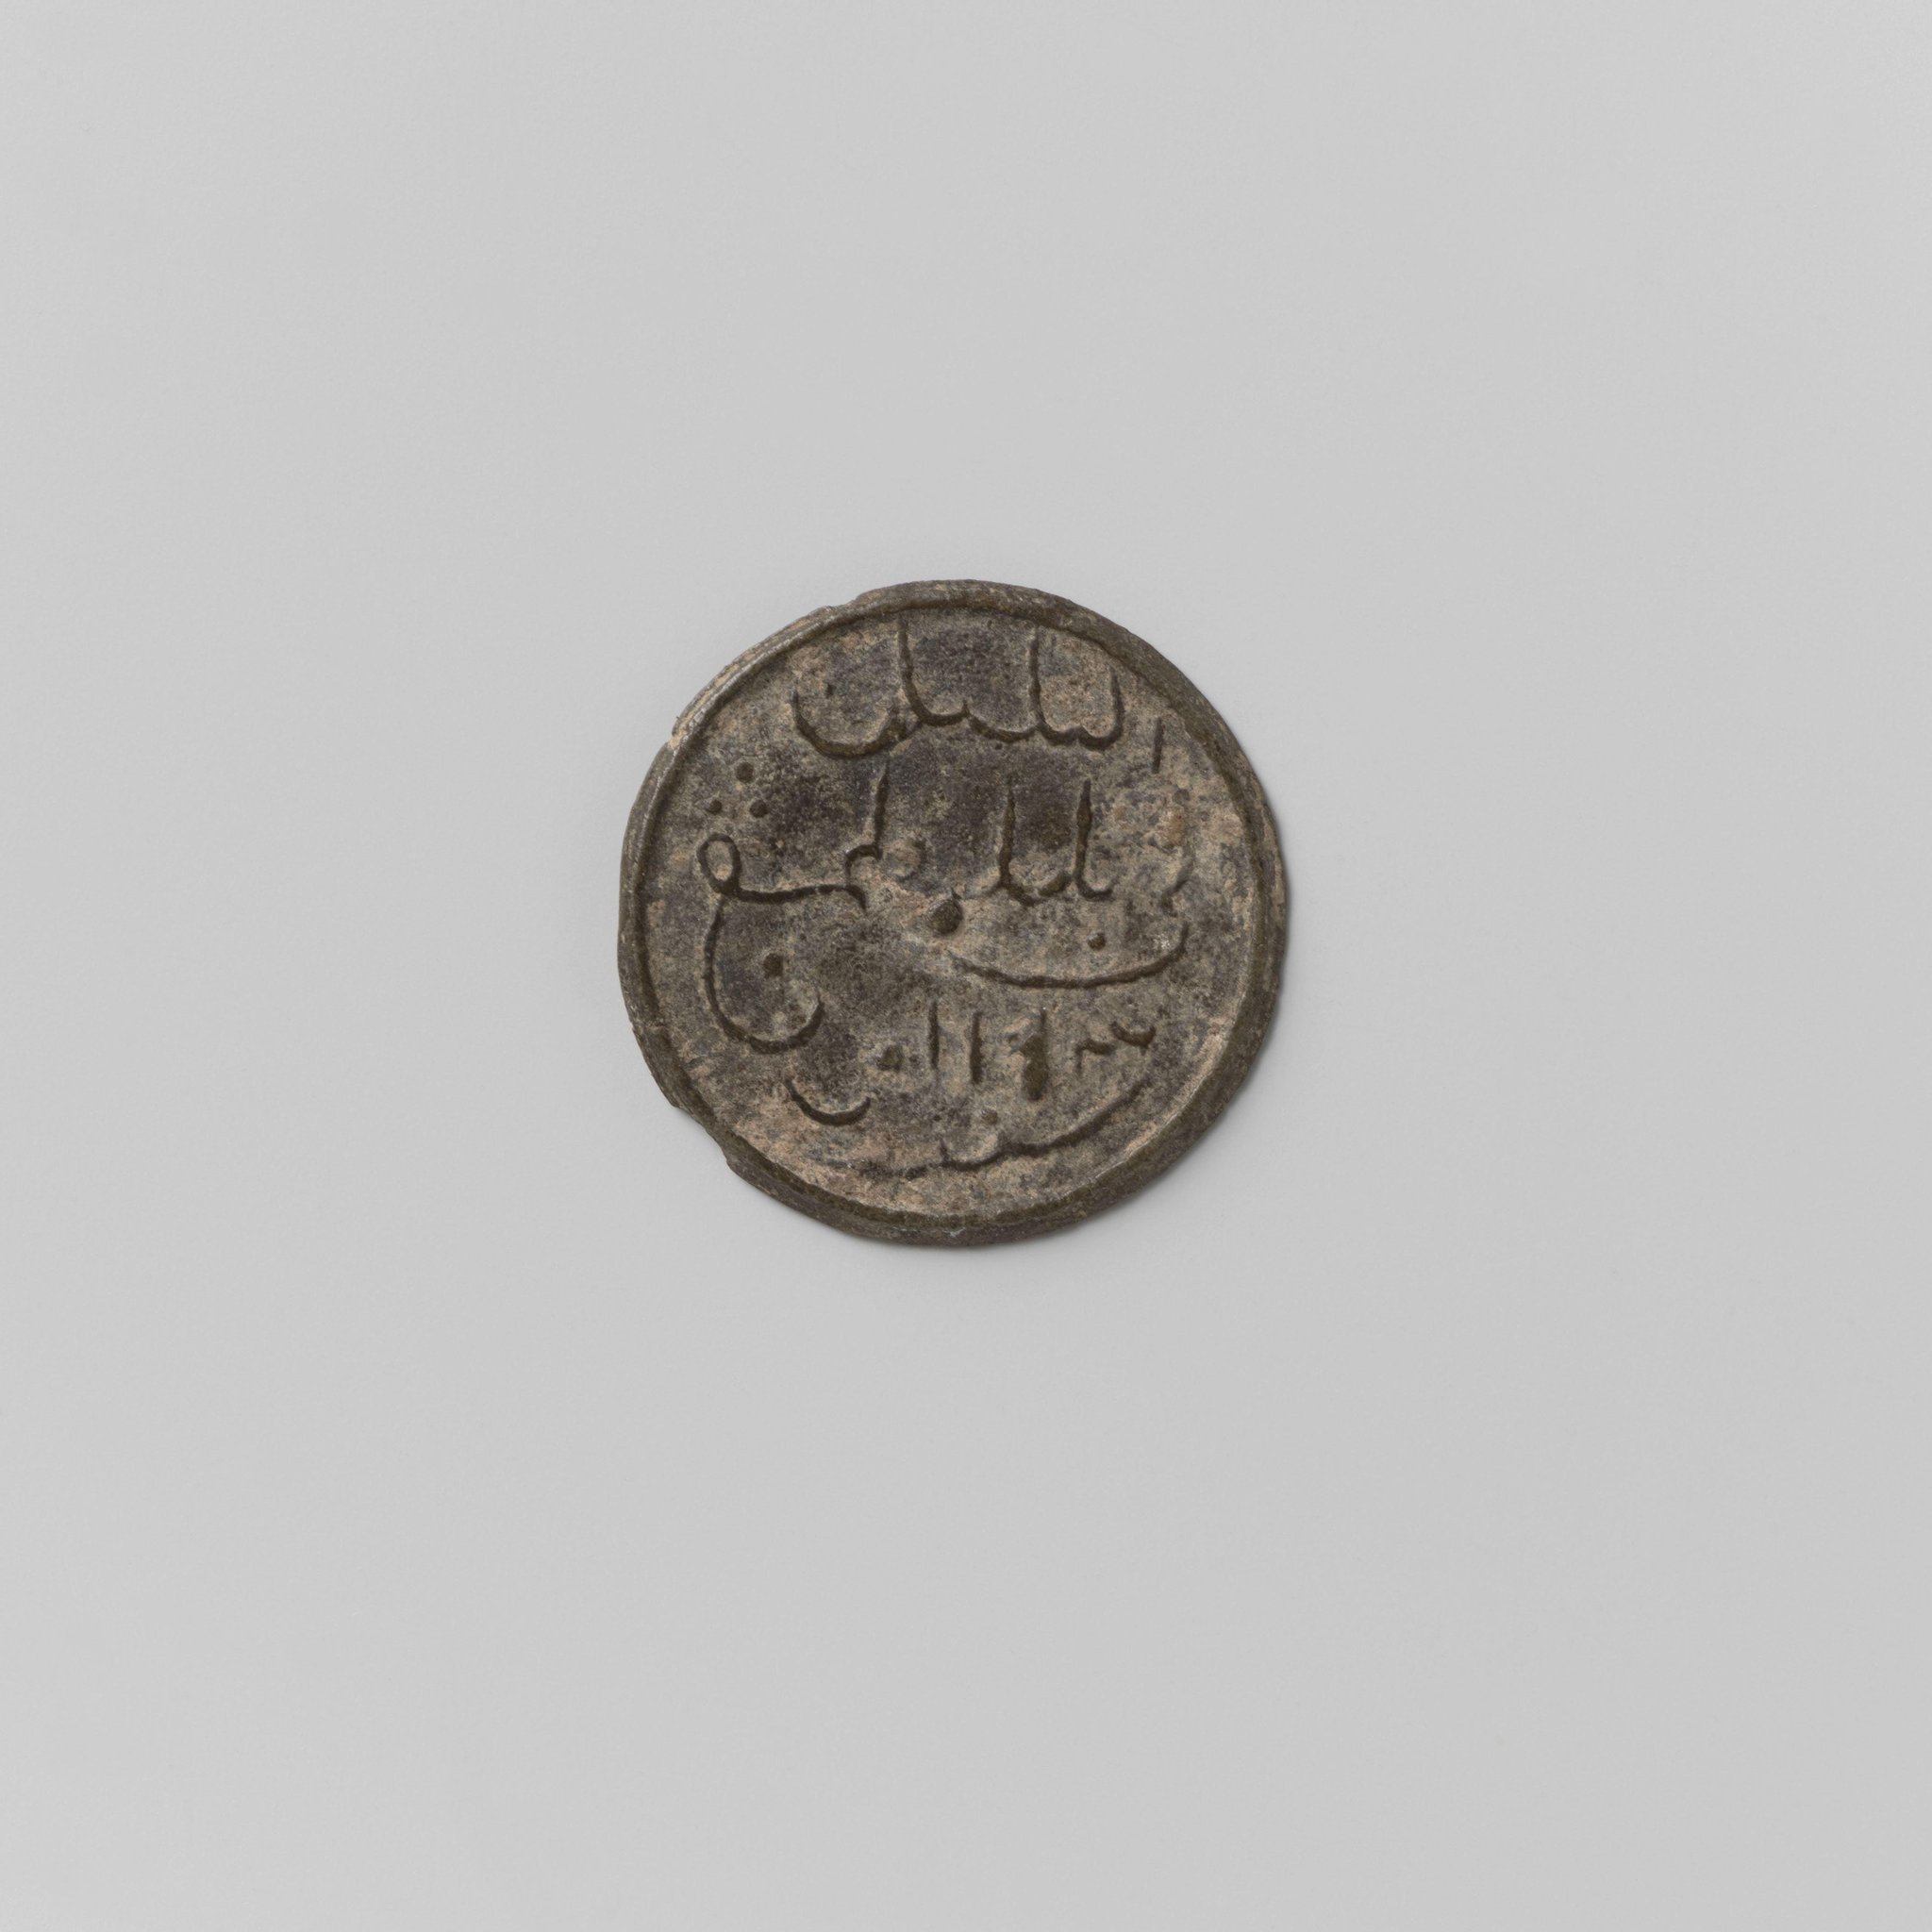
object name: coin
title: Palembang, Sumatra, sultan Mohammed Beha ed-din, pitji, A.H. 1193 (1779)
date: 1779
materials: tin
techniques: casting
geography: palembang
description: Tinnen munt. Voorzijde: drieregelig opschrift in Arabische lettertekens, waartussen jaartal in Islamitische jaartelling. Keerzijde, glad.